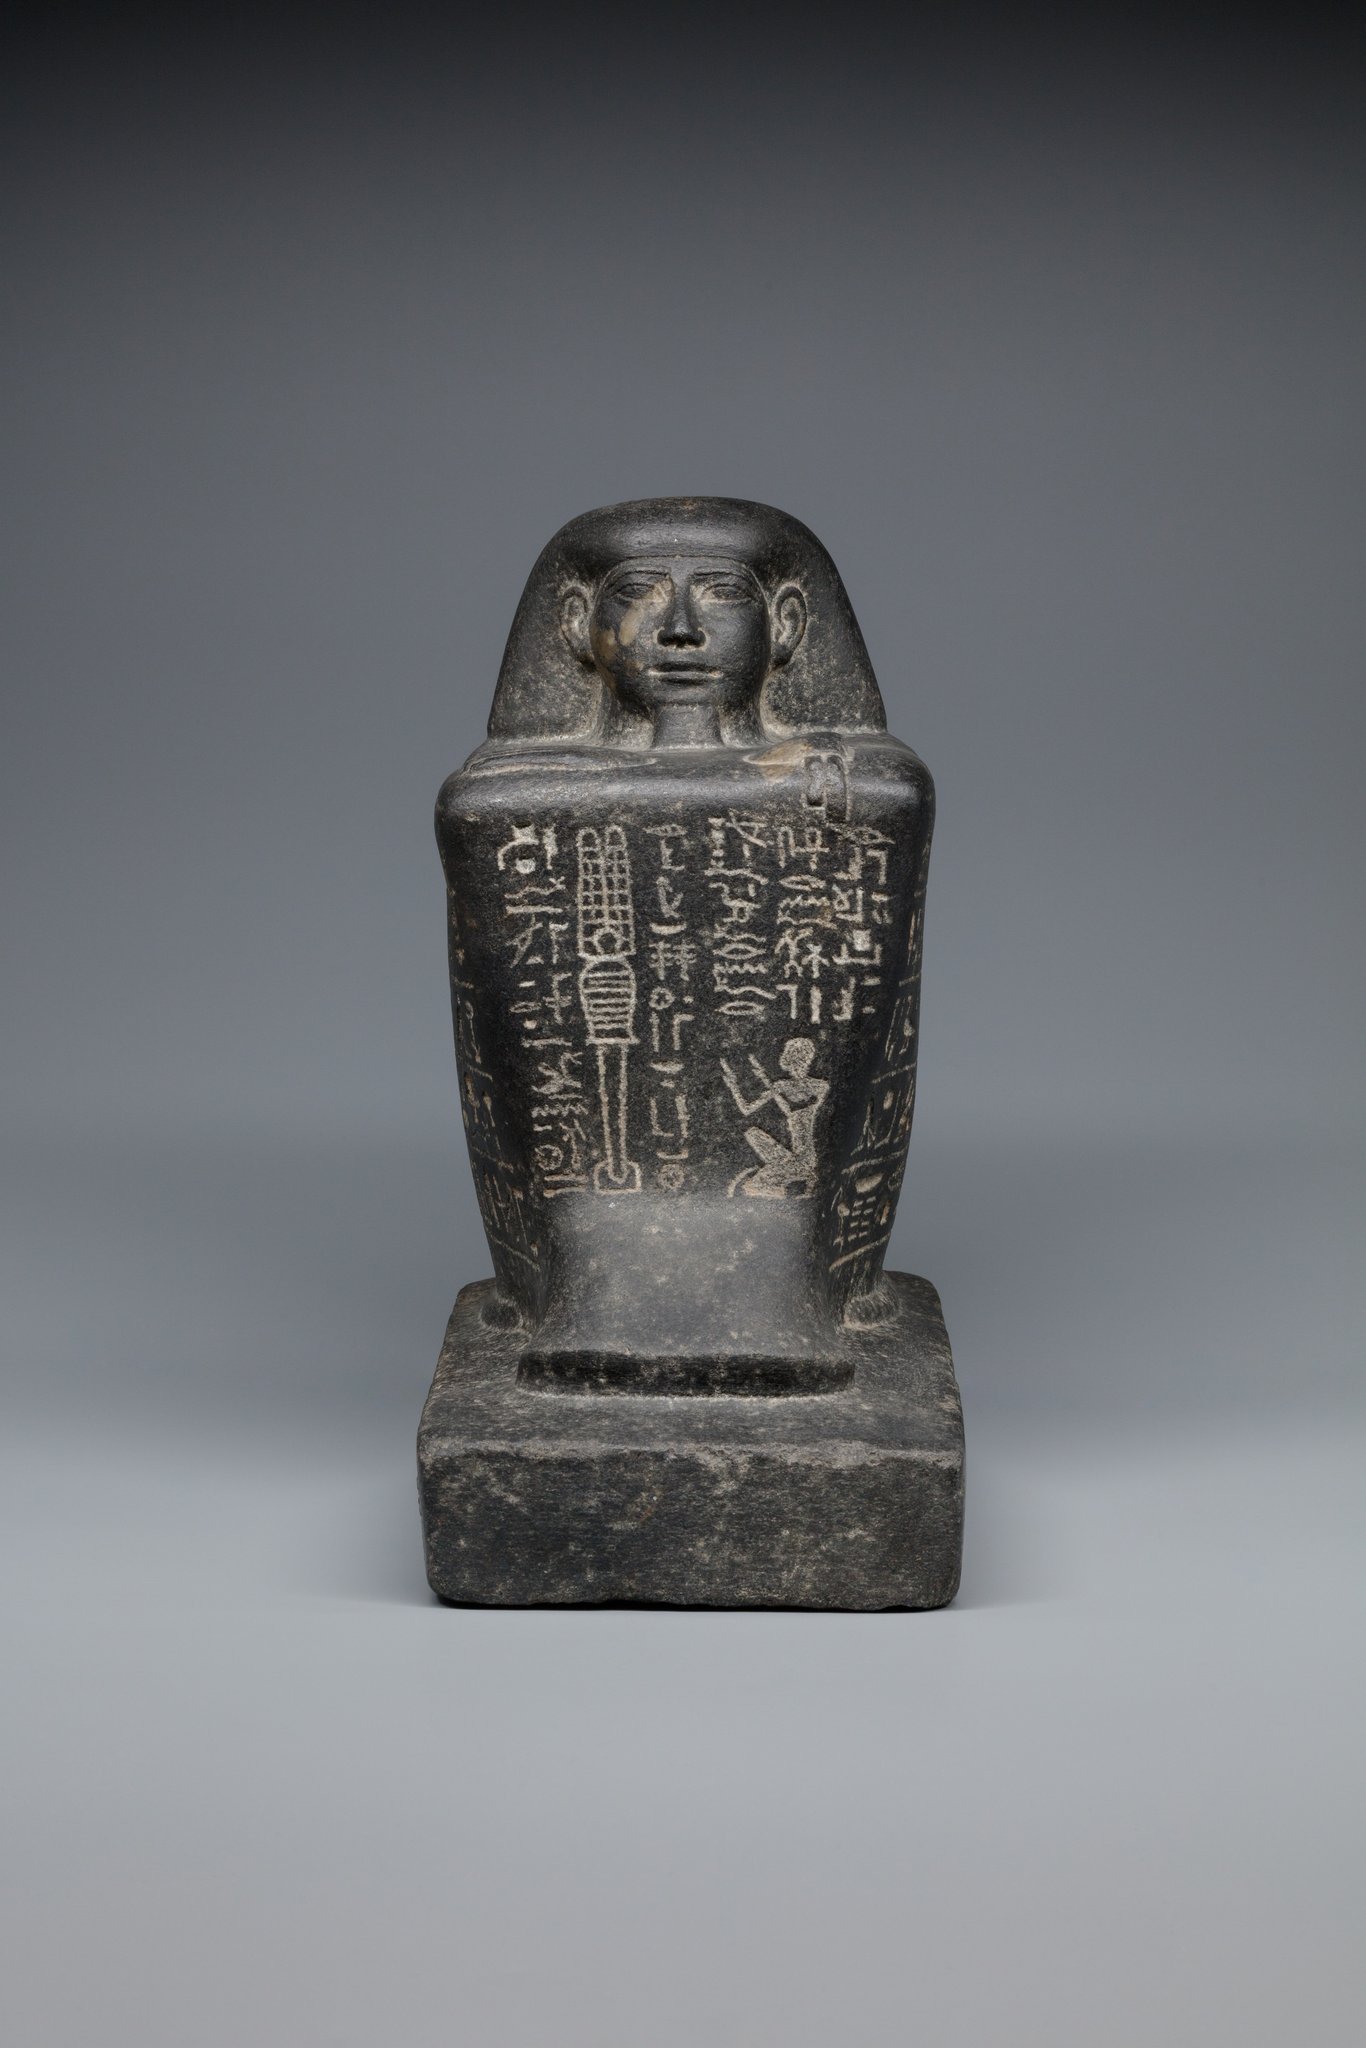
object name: block statue, tjaenwaset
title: Block Statue of the Scribe of Divine Offerings, Tjaenwaset, son of Harsiese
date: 690-610 BCE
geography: egypt